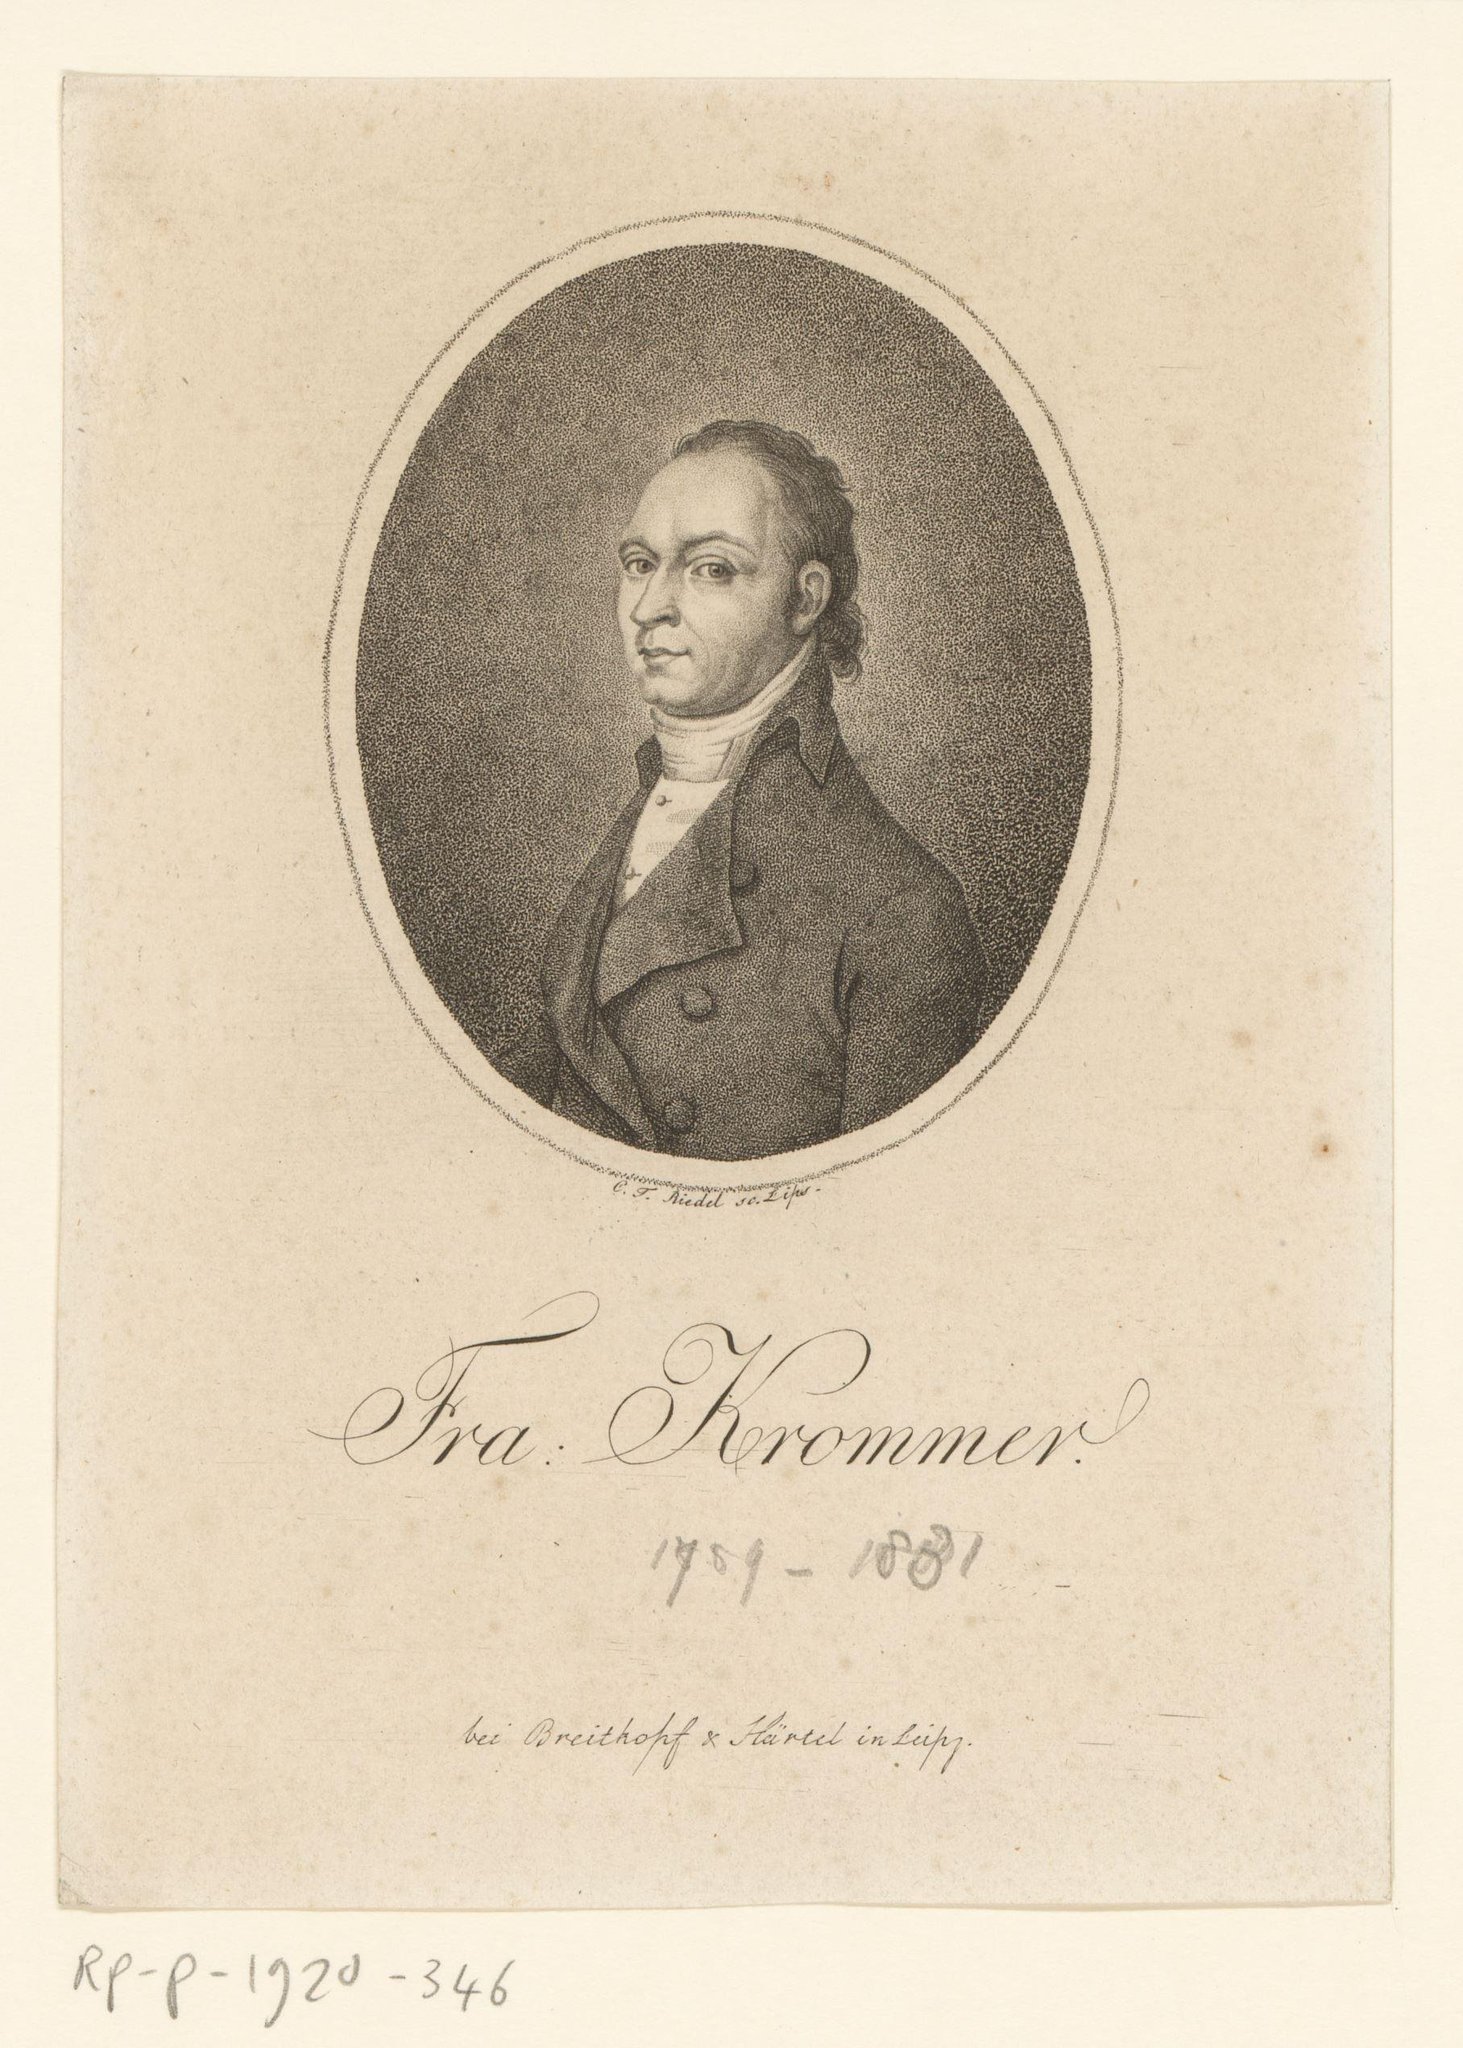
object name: print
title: Portret van Franz Krommer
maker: karl traugott riedel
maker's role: print maker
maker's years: 1769-1832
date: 1779-1850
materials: paper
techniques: engraving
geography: leipzig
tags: vienna, musician, historical persons, portrait of composer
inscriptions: number, collector's mark: Lugt 2228